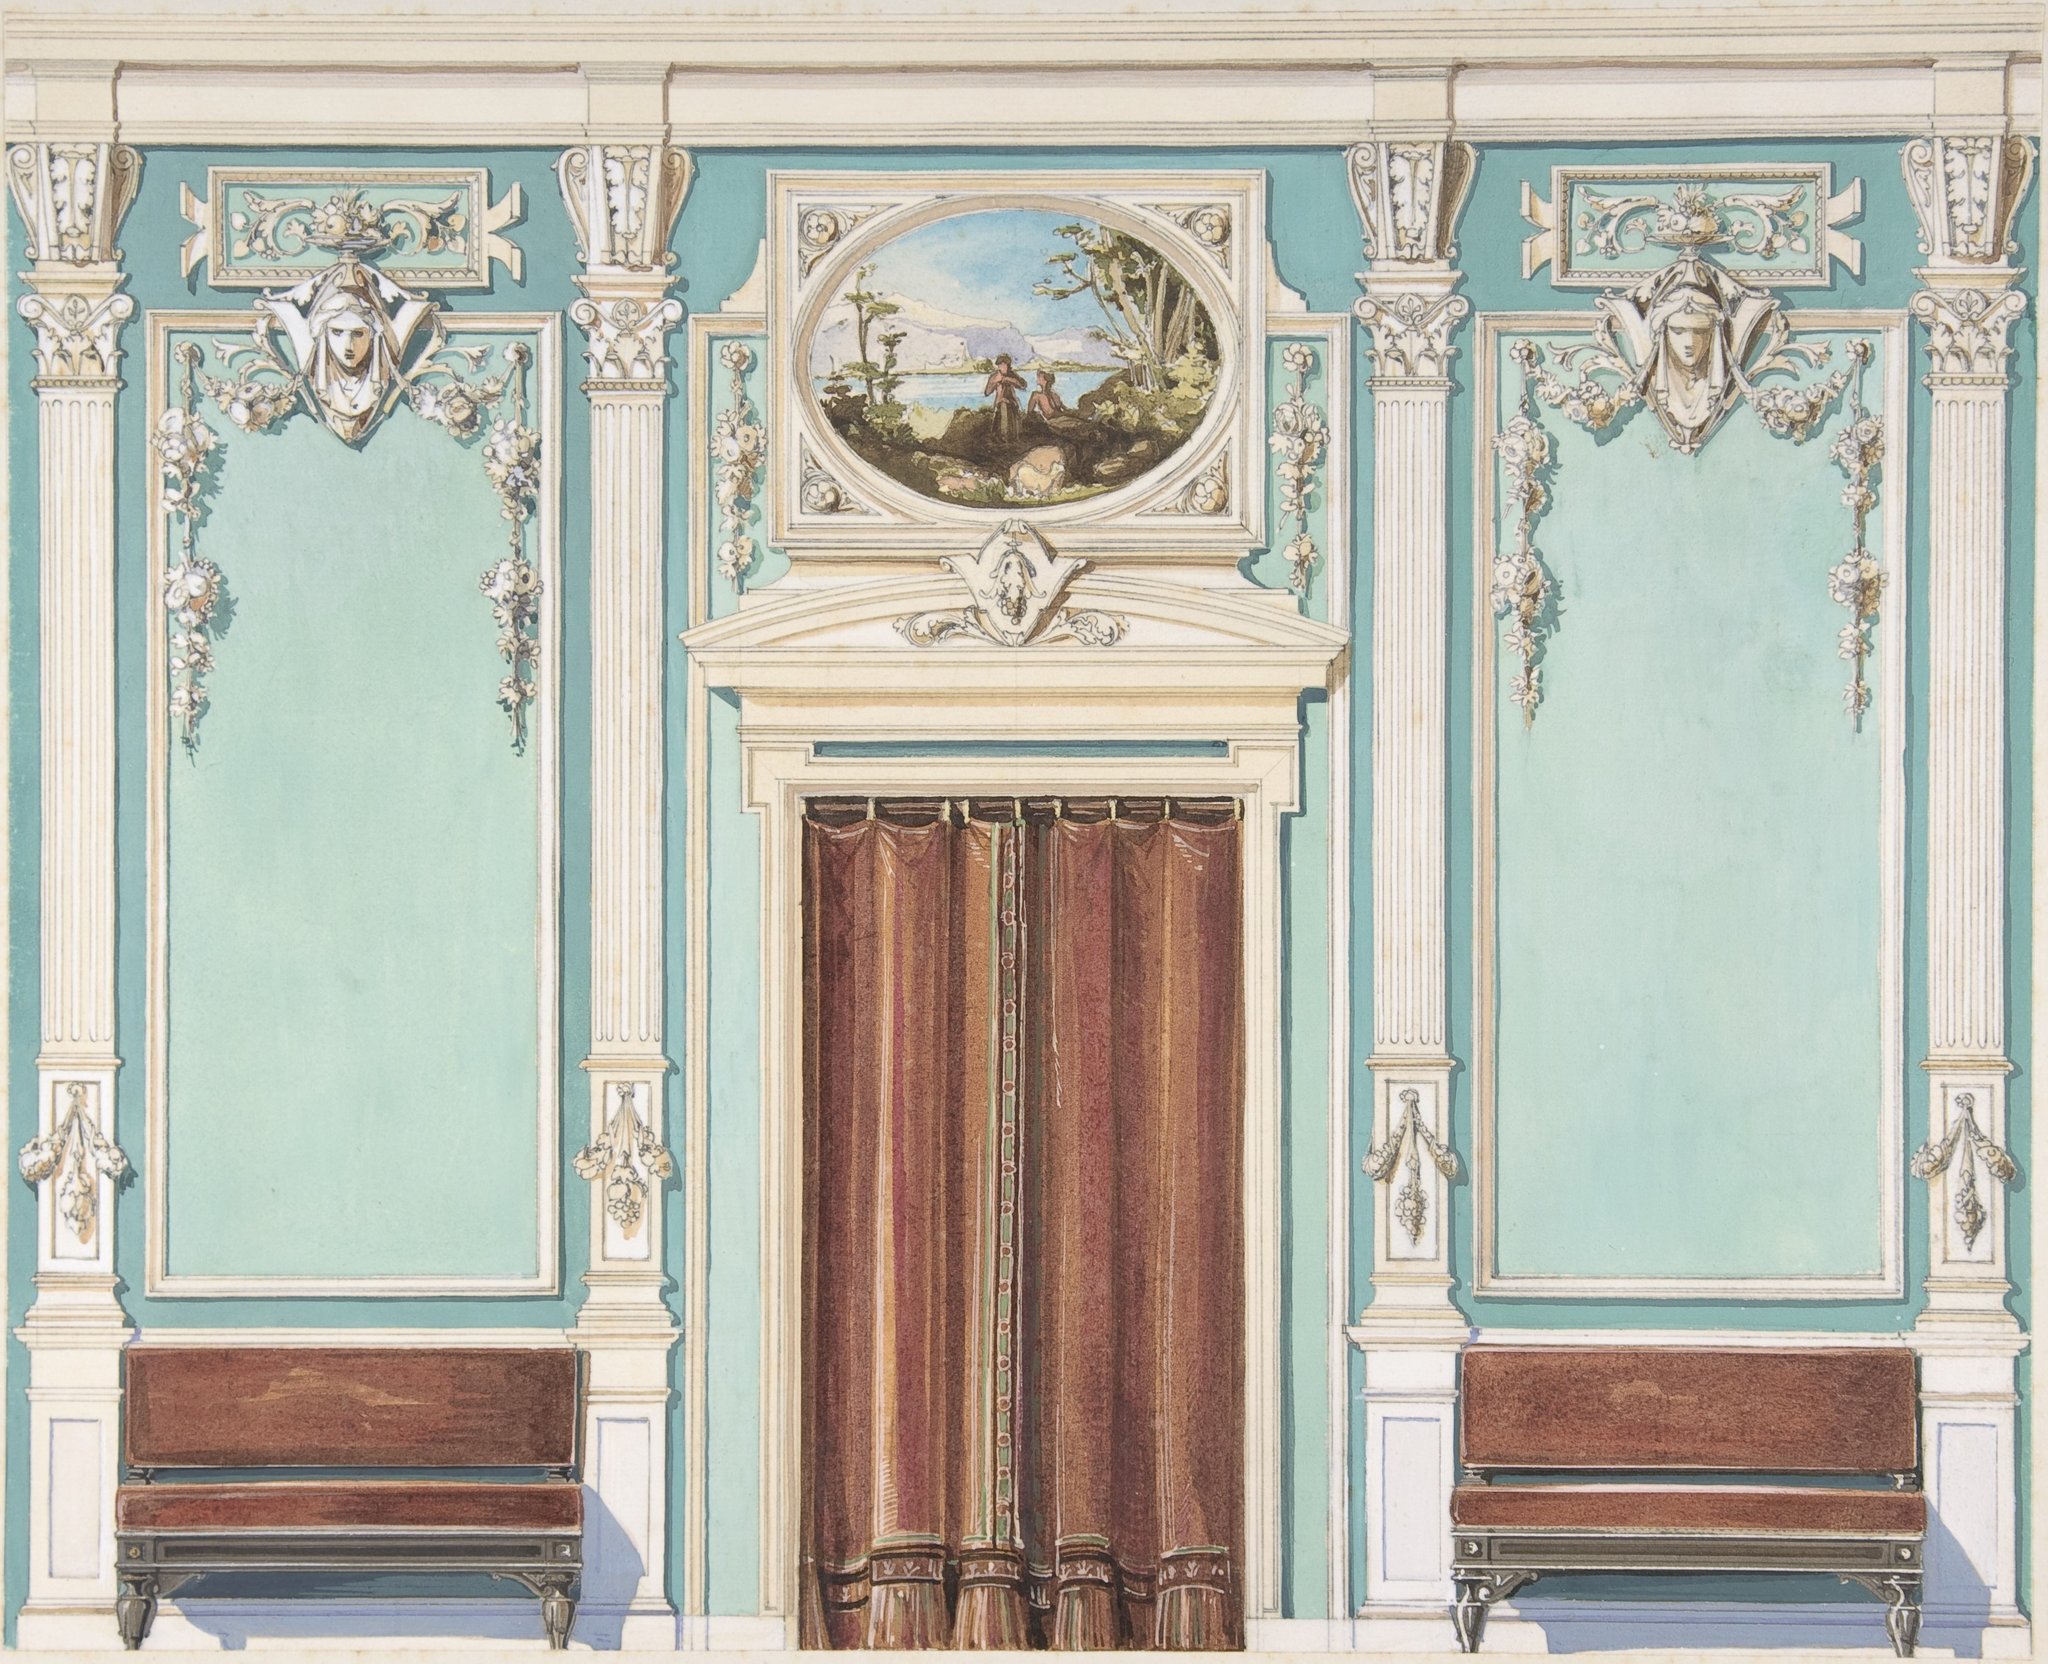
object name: drawing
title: Interior Design with a Central Door with Brown Curtains Flanked by Benches, against an Aquamarine Wall, with an Overdoor Painting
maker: anonymous, british, 19th century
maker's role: artist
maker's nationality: british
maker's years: 1800-1900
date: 1867-1900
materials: gouache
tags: architecture,interiors,curtains,benches